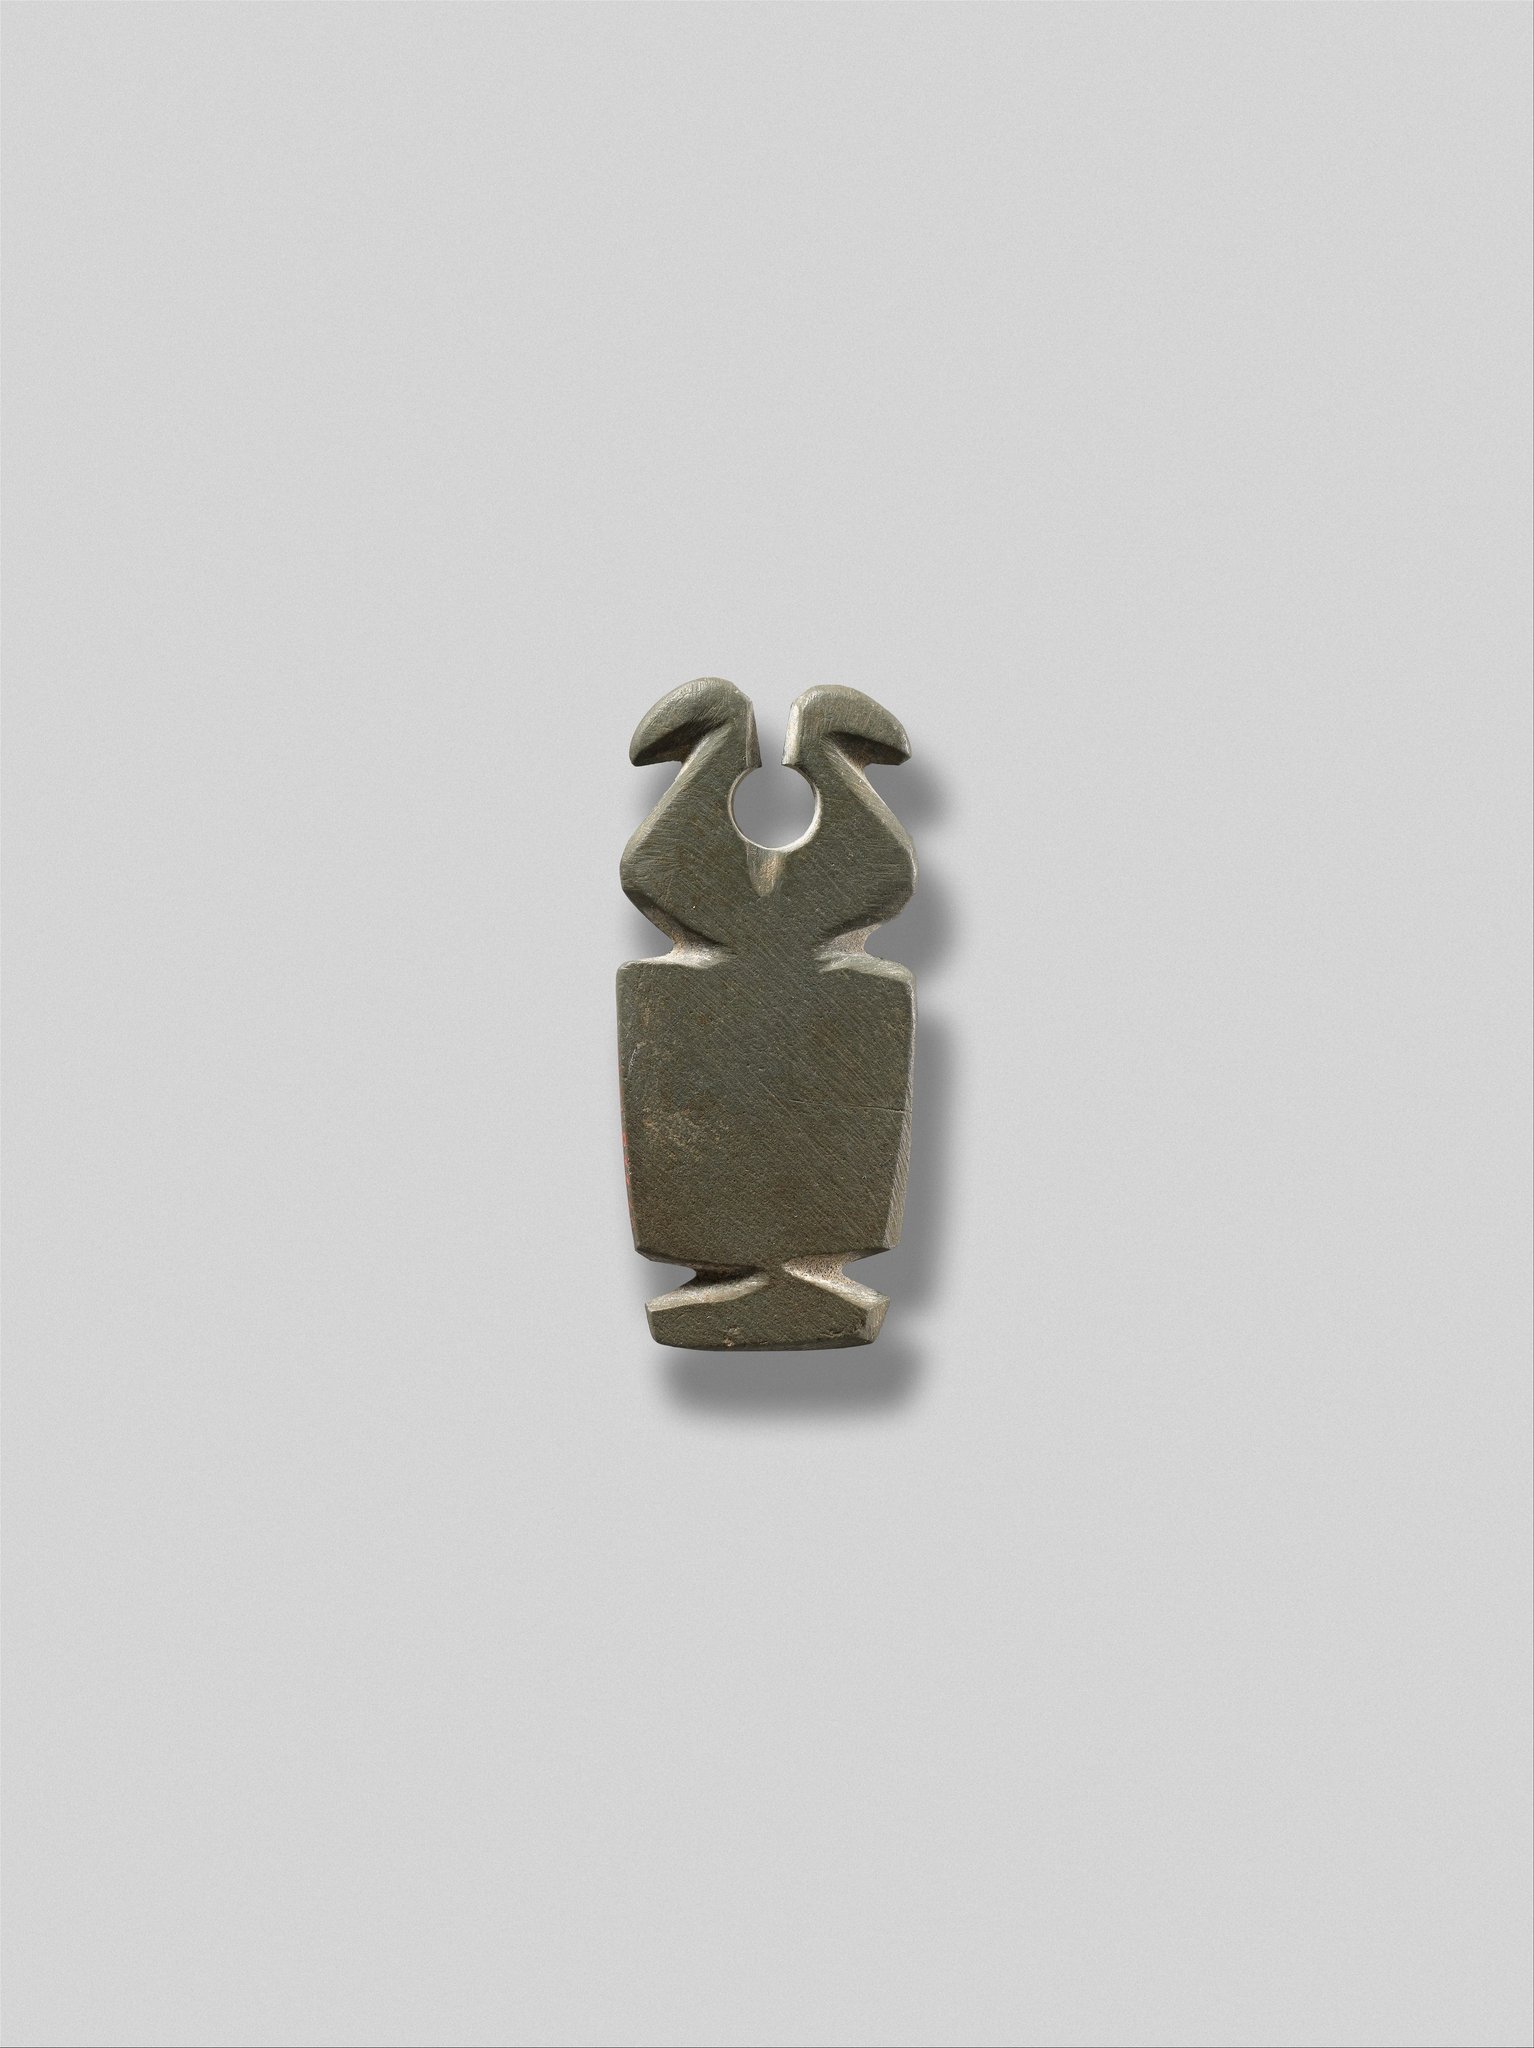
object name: amulet, double horn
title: Amulet emphasizing a pair of horns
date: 3650-3300 BCE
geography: egypt